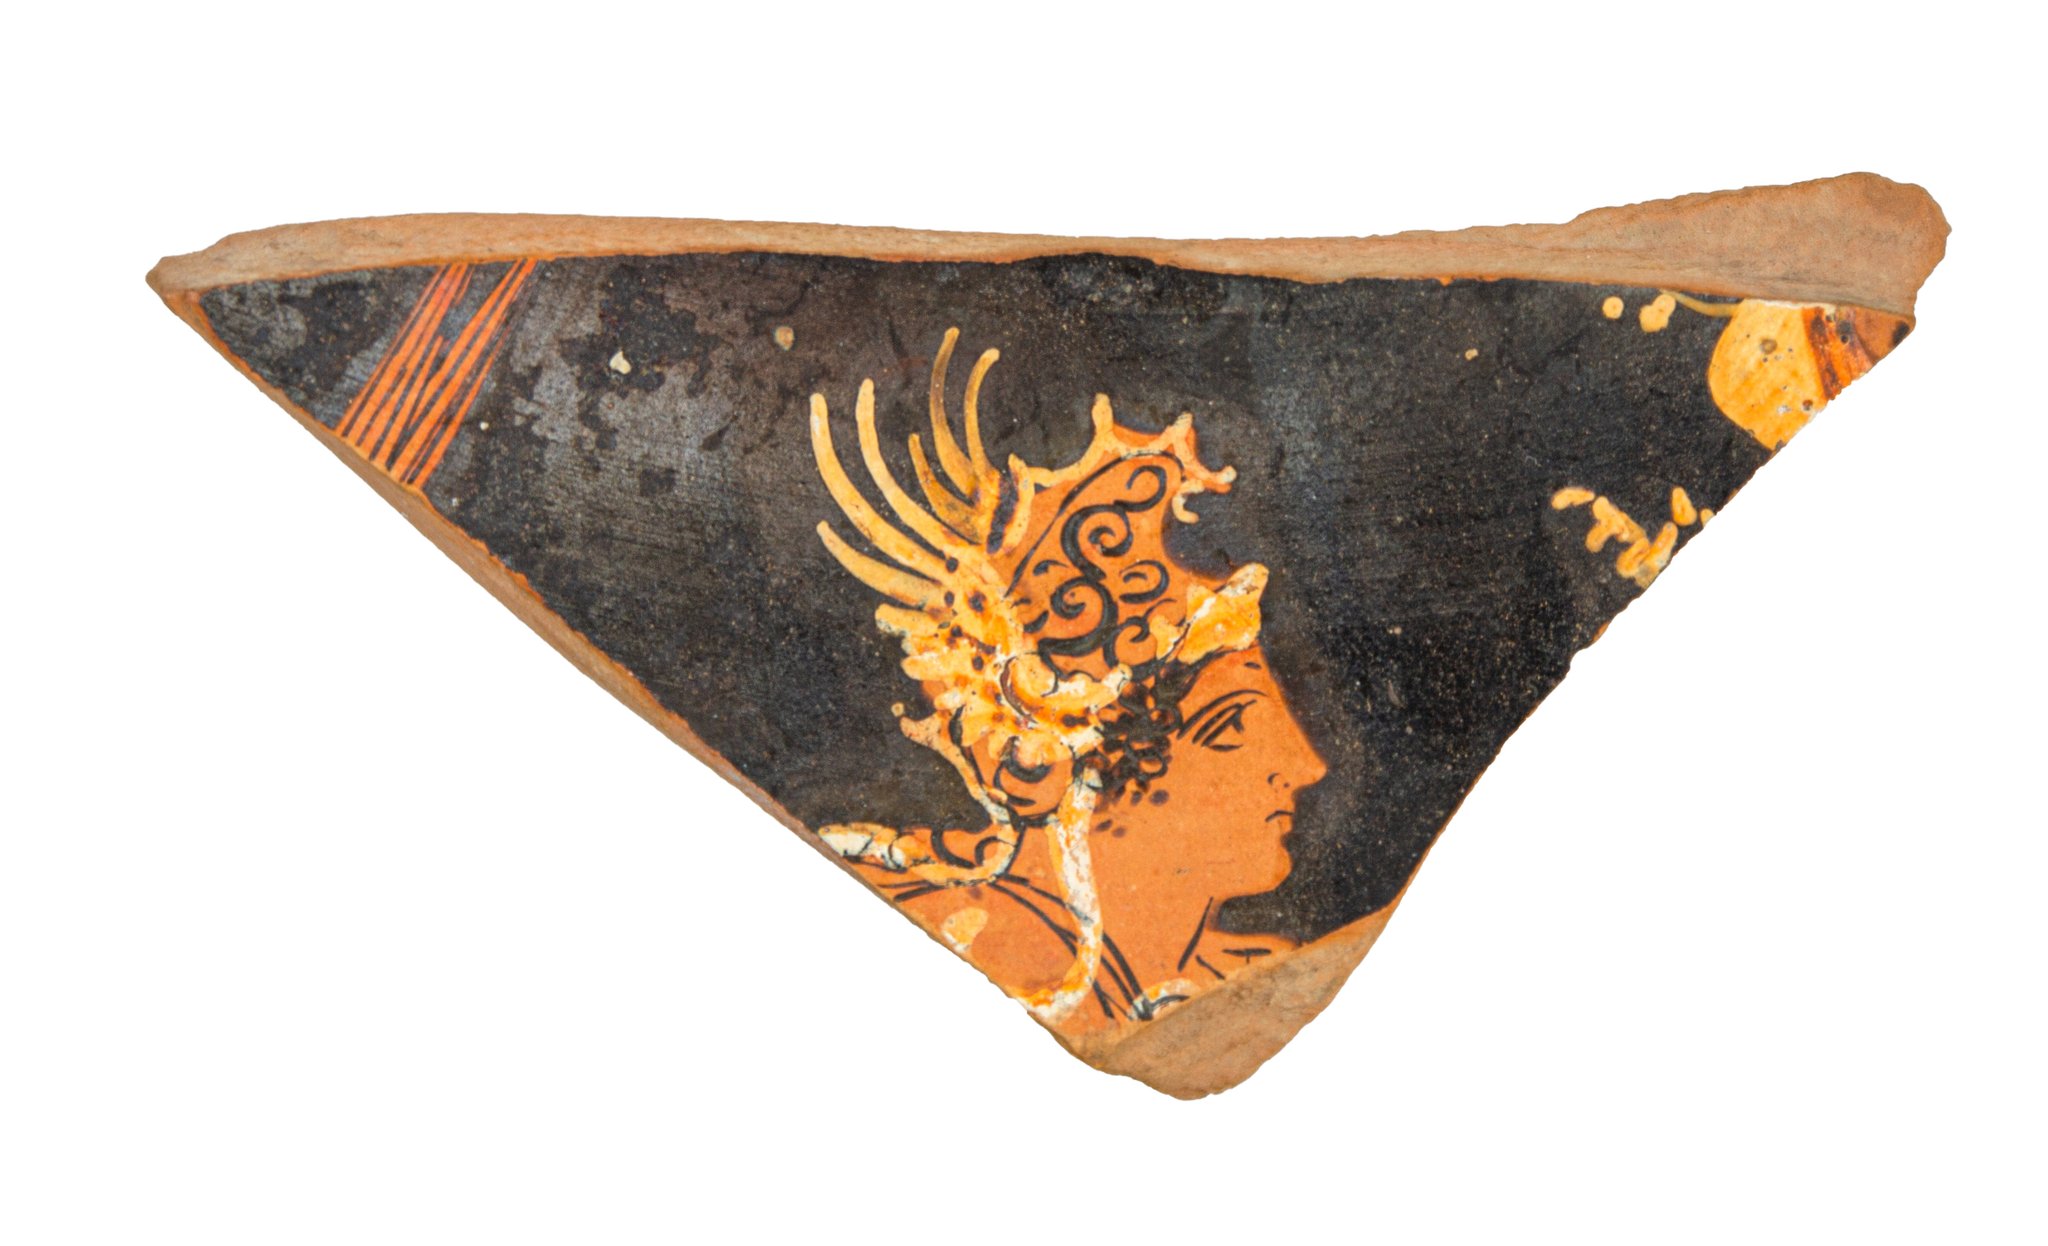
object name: pelike, fragmentary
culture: greek, south italian, apulian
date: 330-300 BCE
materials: terracotta